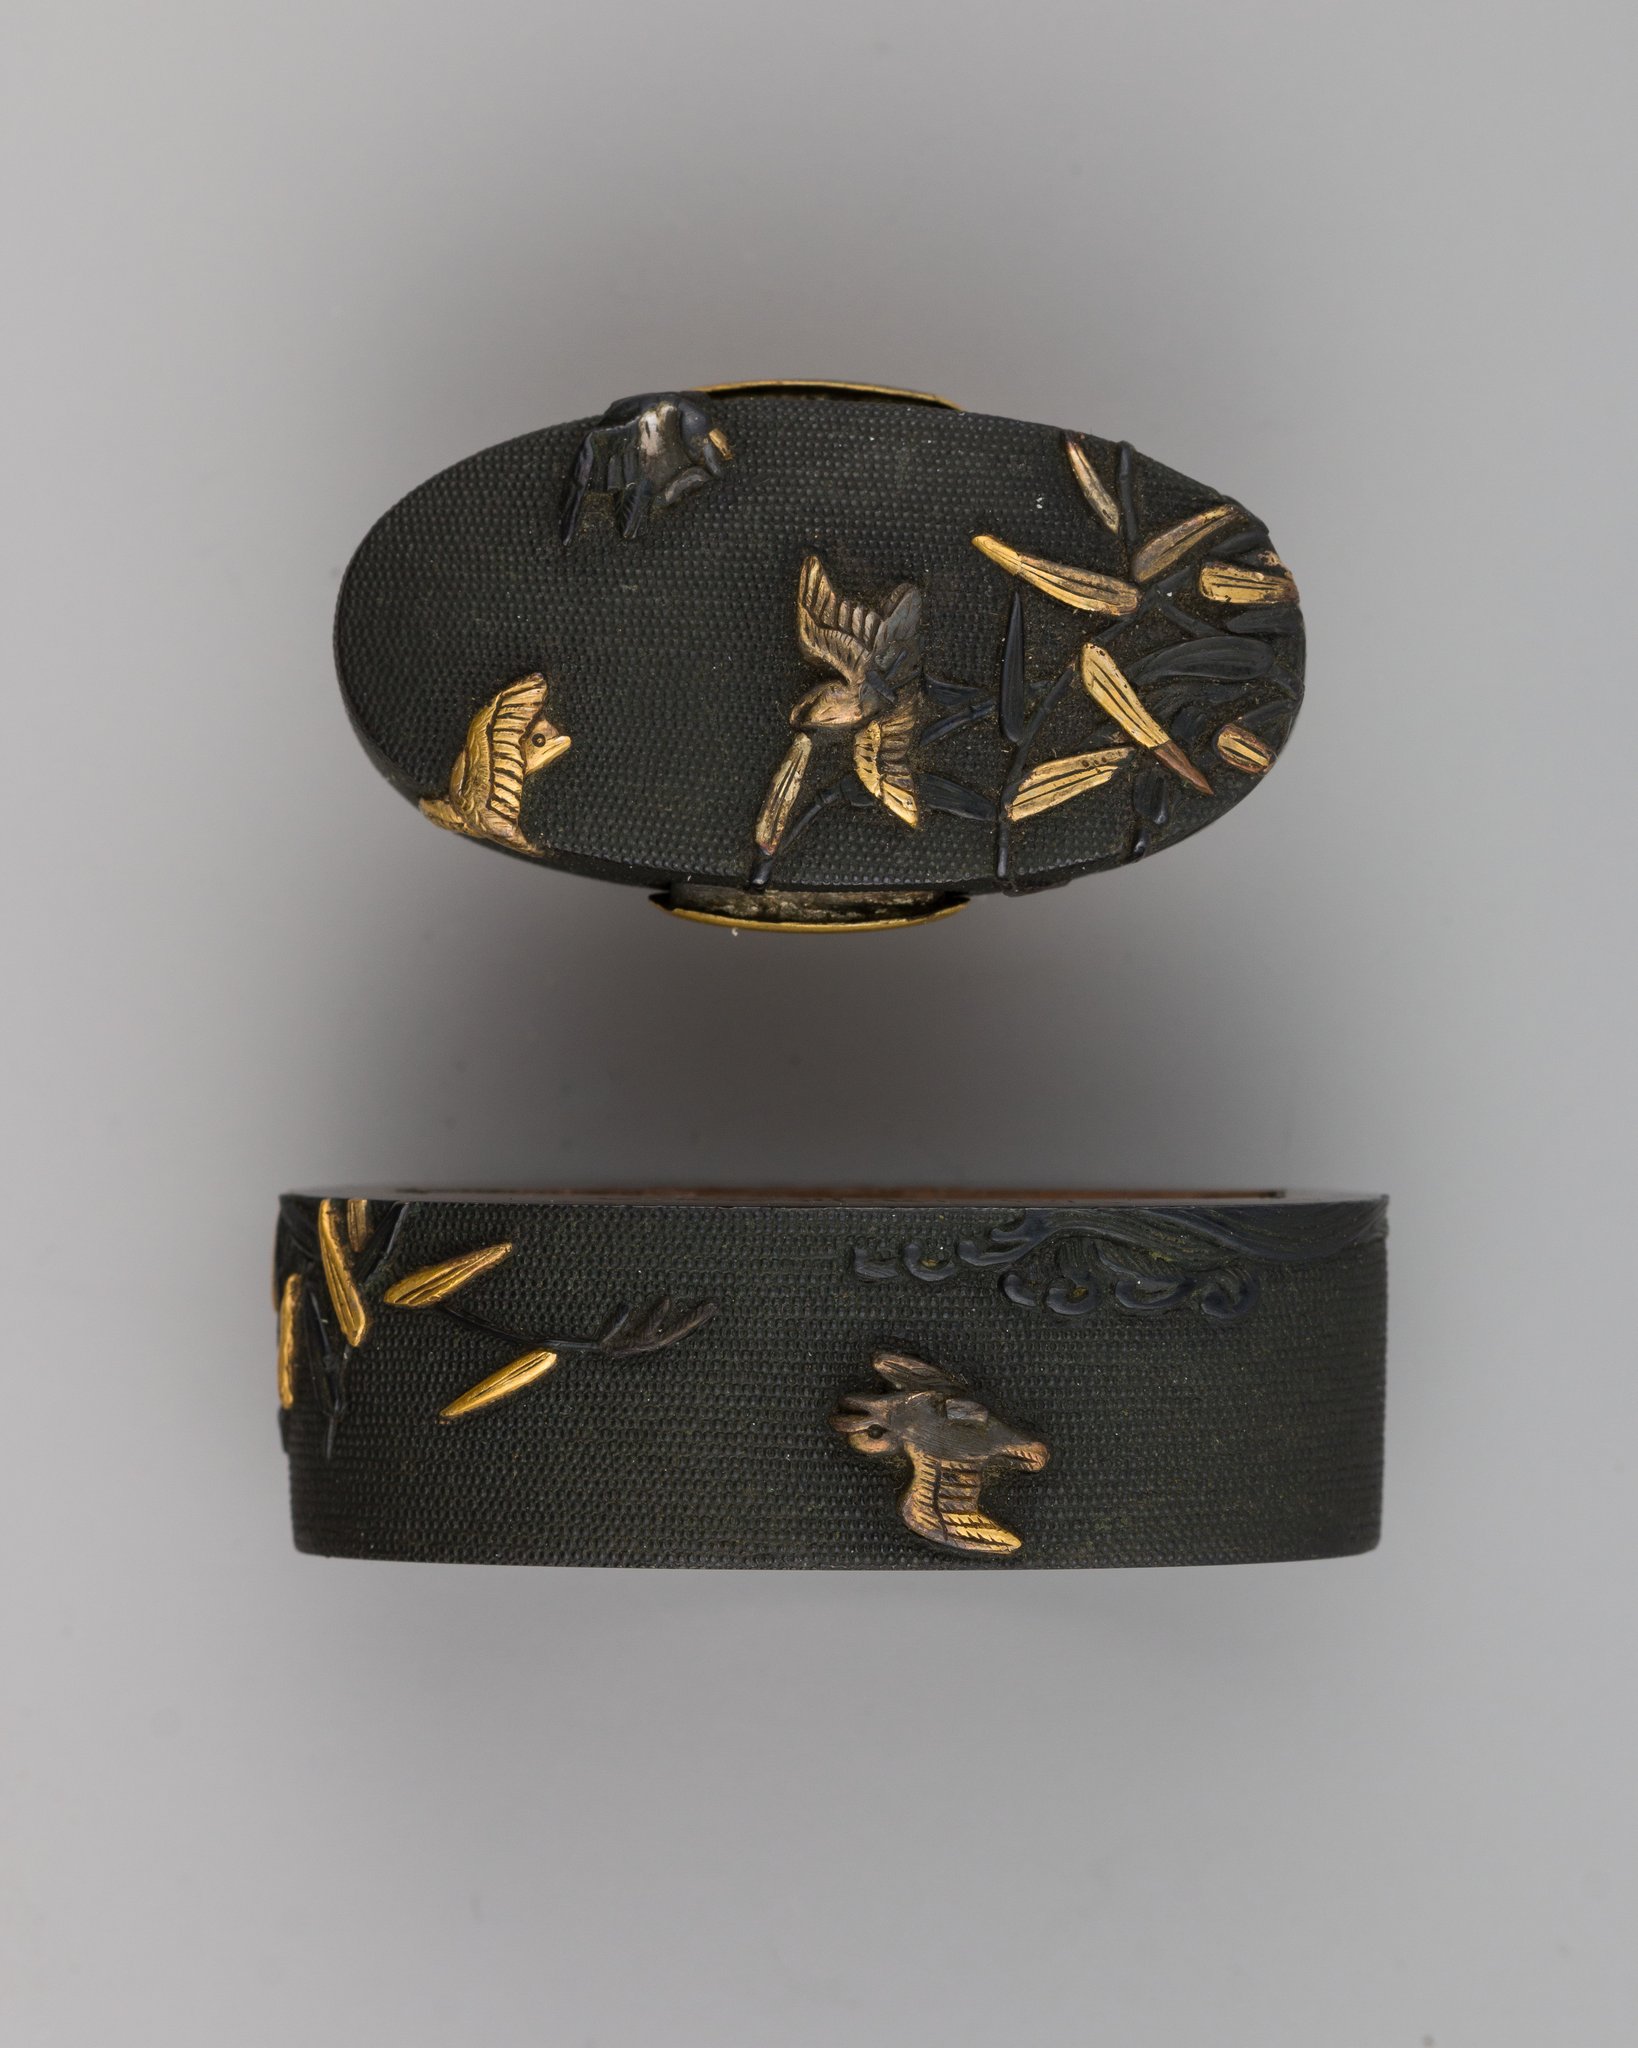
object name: sword hilt collar and pommel fuchigashira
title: Sword-Hilt Collar and Pommel (Fuchigashira)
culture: japanese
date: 1701-1800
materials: gold alloy, gold, silver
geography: japan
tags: birds,leaves